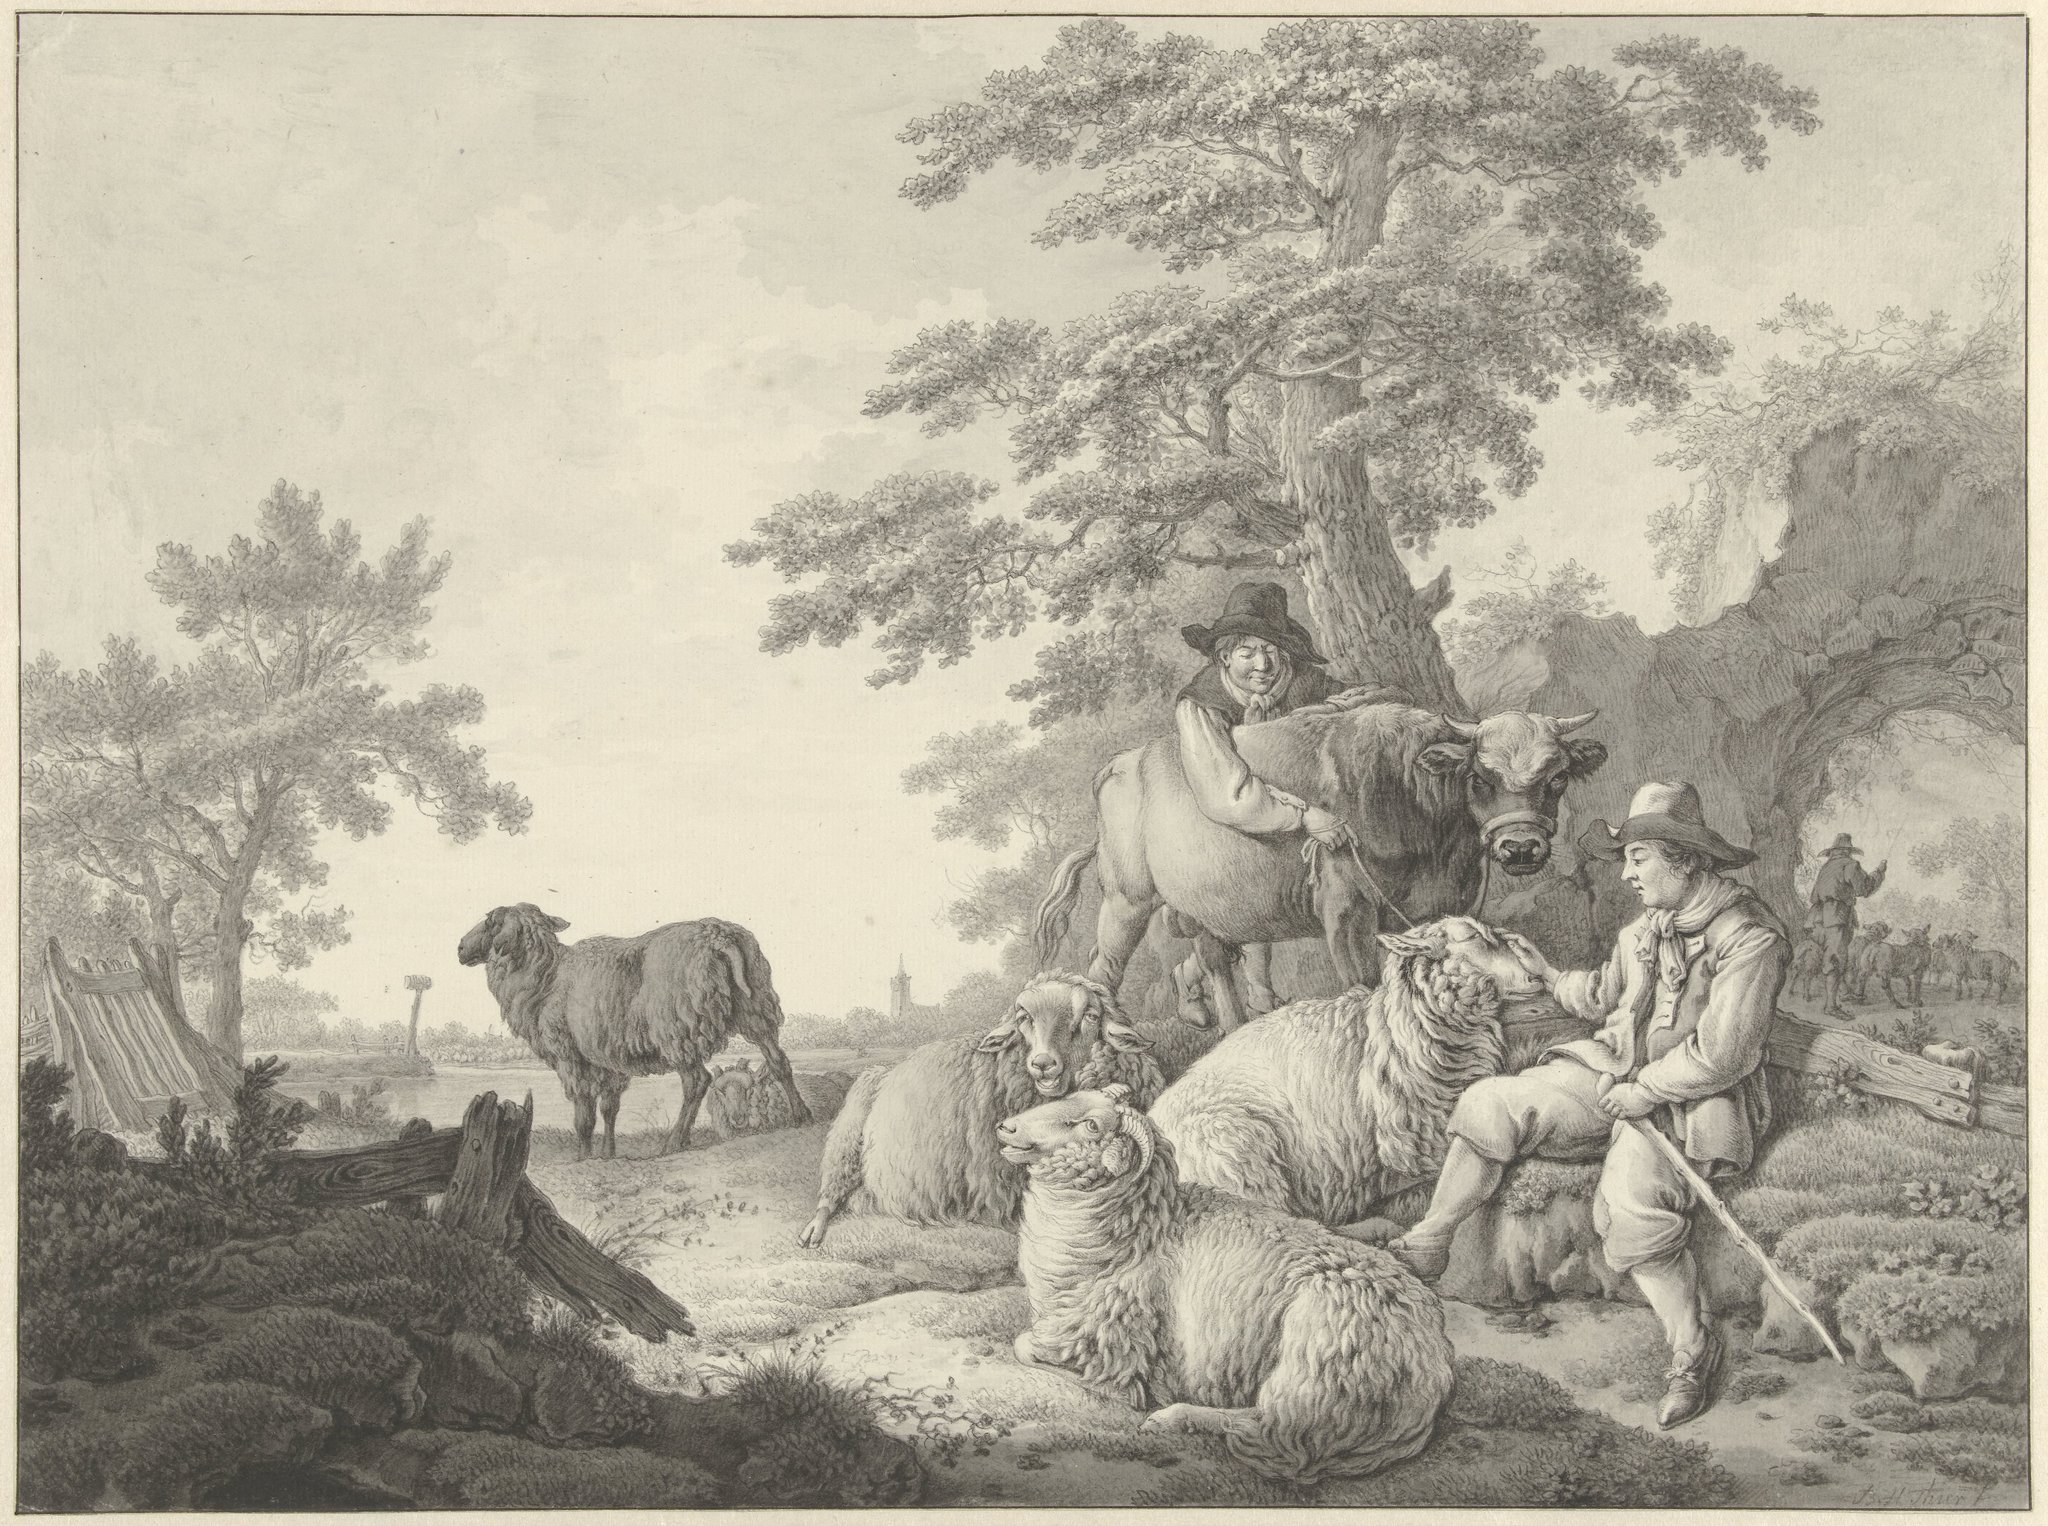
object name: drawing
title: Schaapherder met schapen en een jongen met een jonge stier in een landschap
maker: barend hendrik thier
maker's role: draughtsman, print maker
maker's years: 1743-1811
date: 1750-1811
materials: chalk, paper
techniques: brush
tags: bull, sheep, occupations ~ cattle, rock-formations